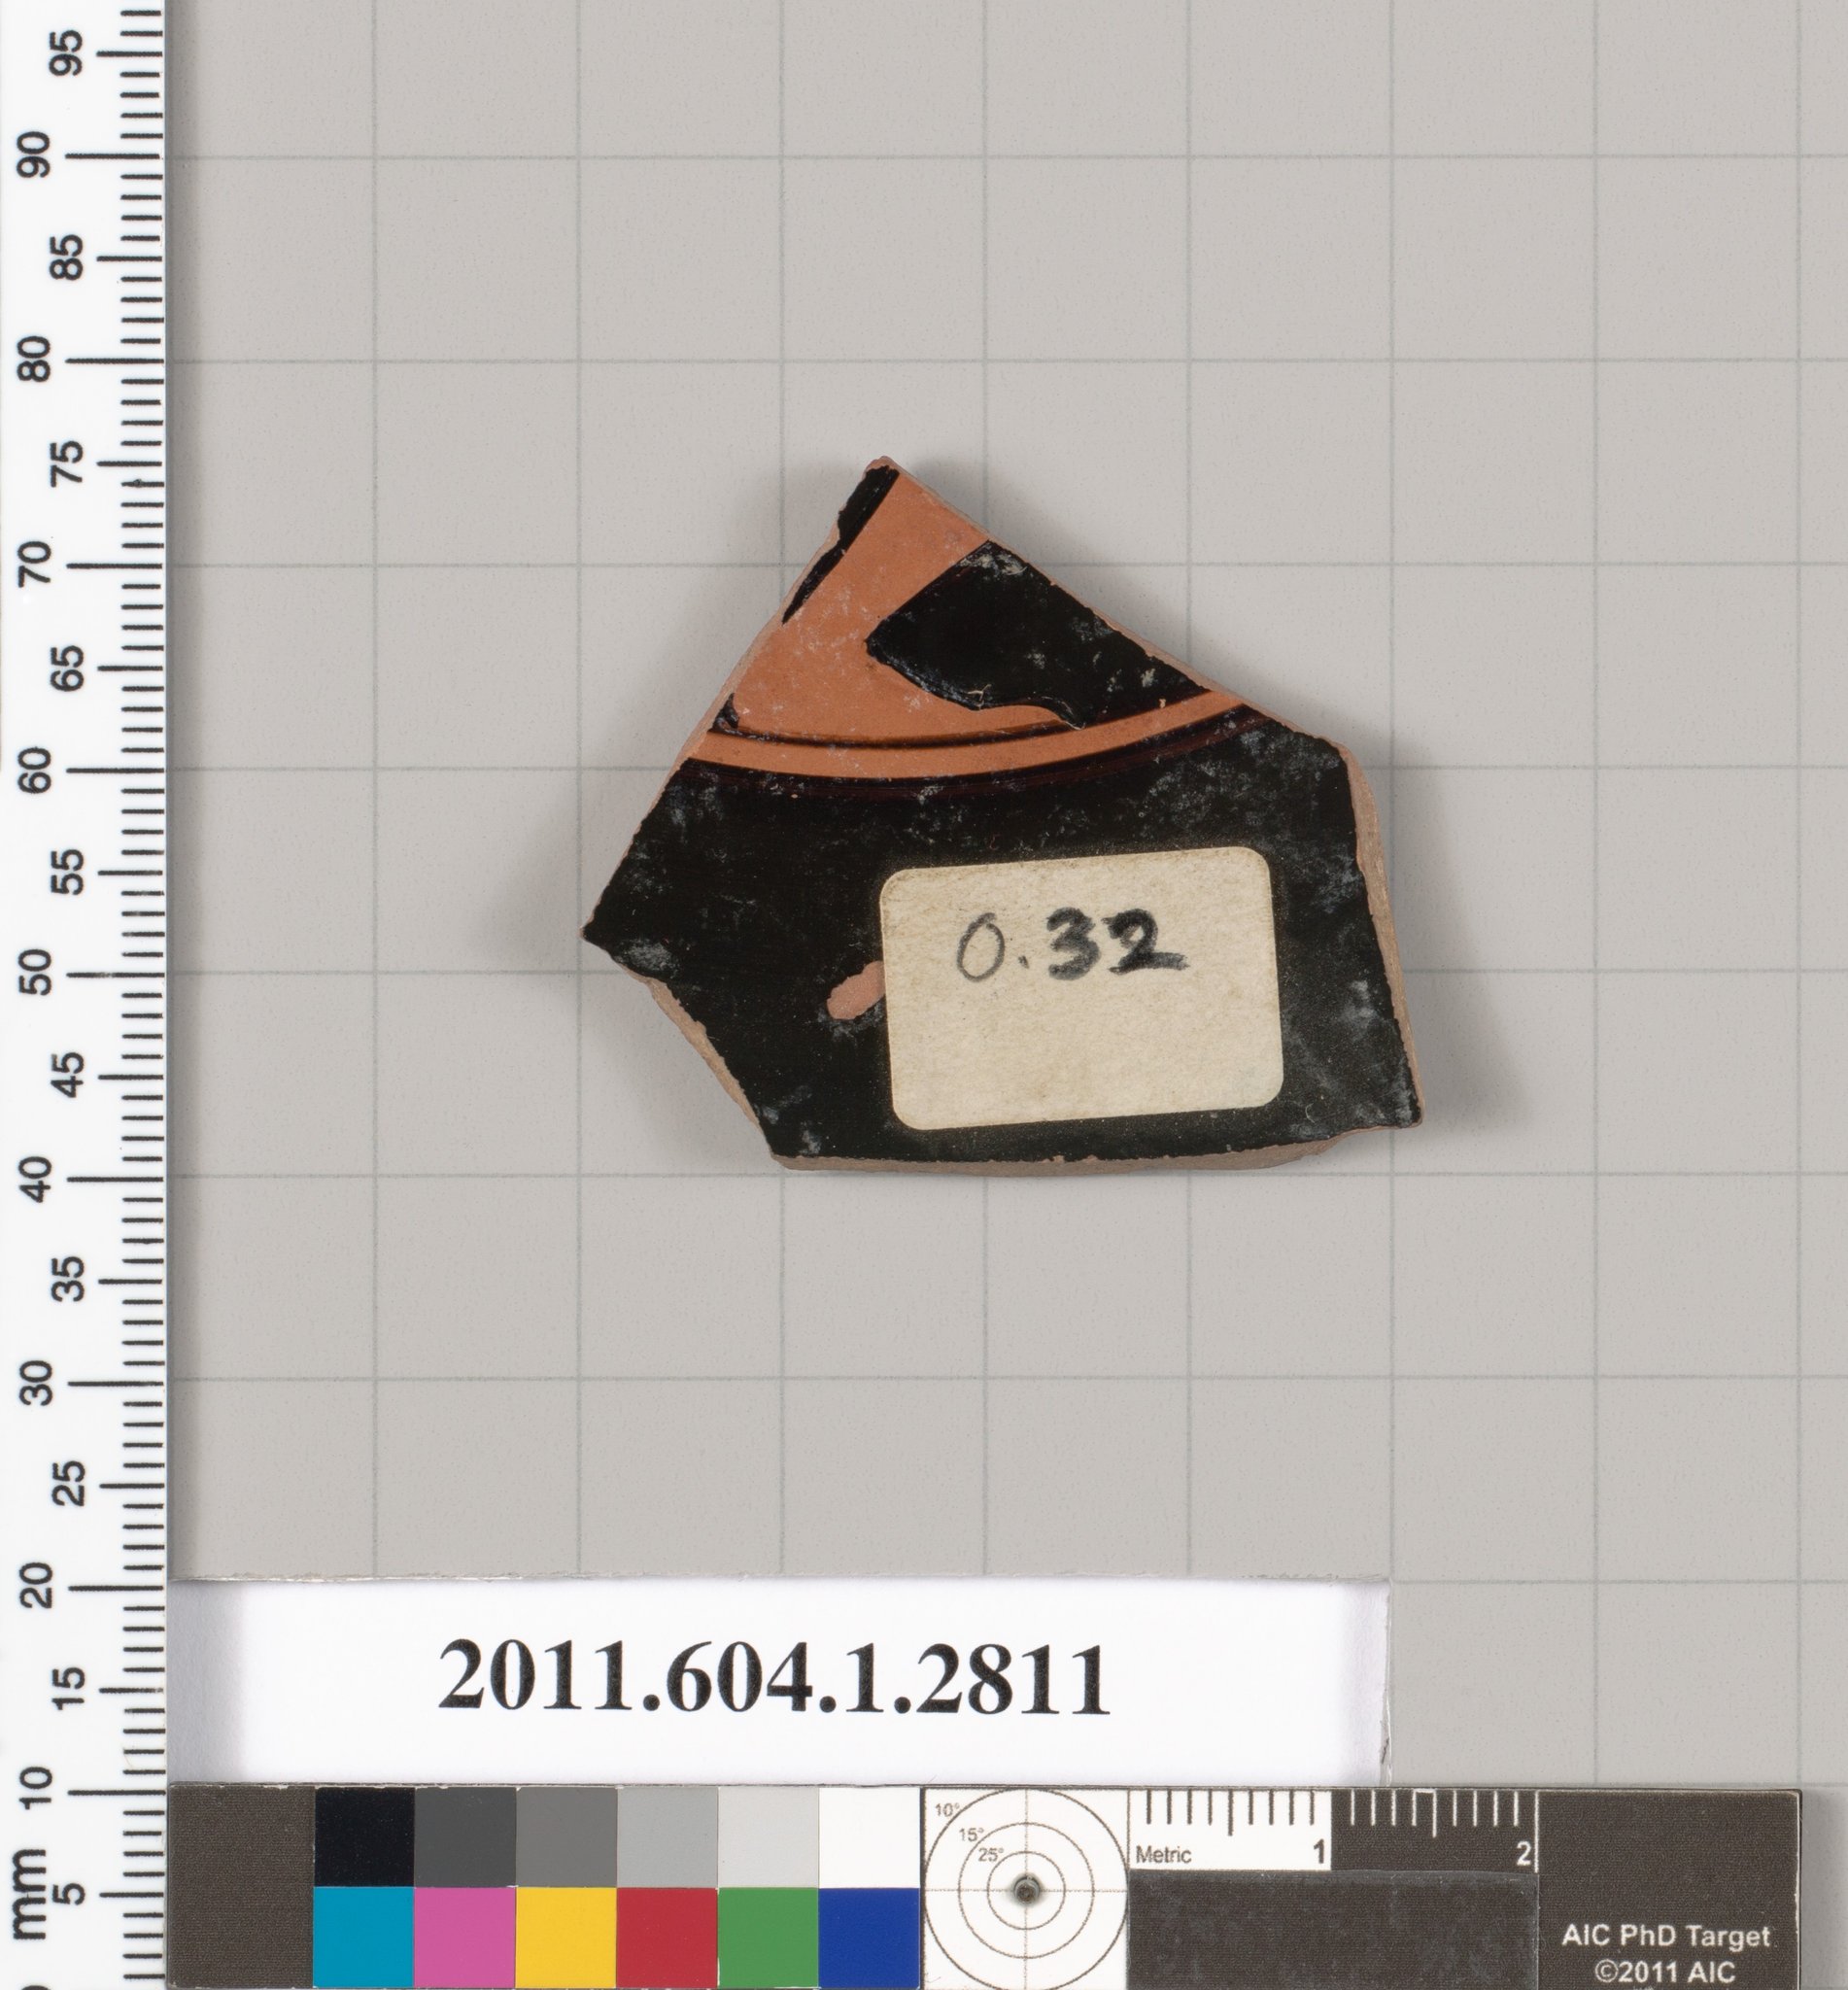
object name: kylix fragment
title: Terracotta fragment of a kylix (drinking cup)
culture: greek, attic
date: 520-500 BCE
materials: terracotta